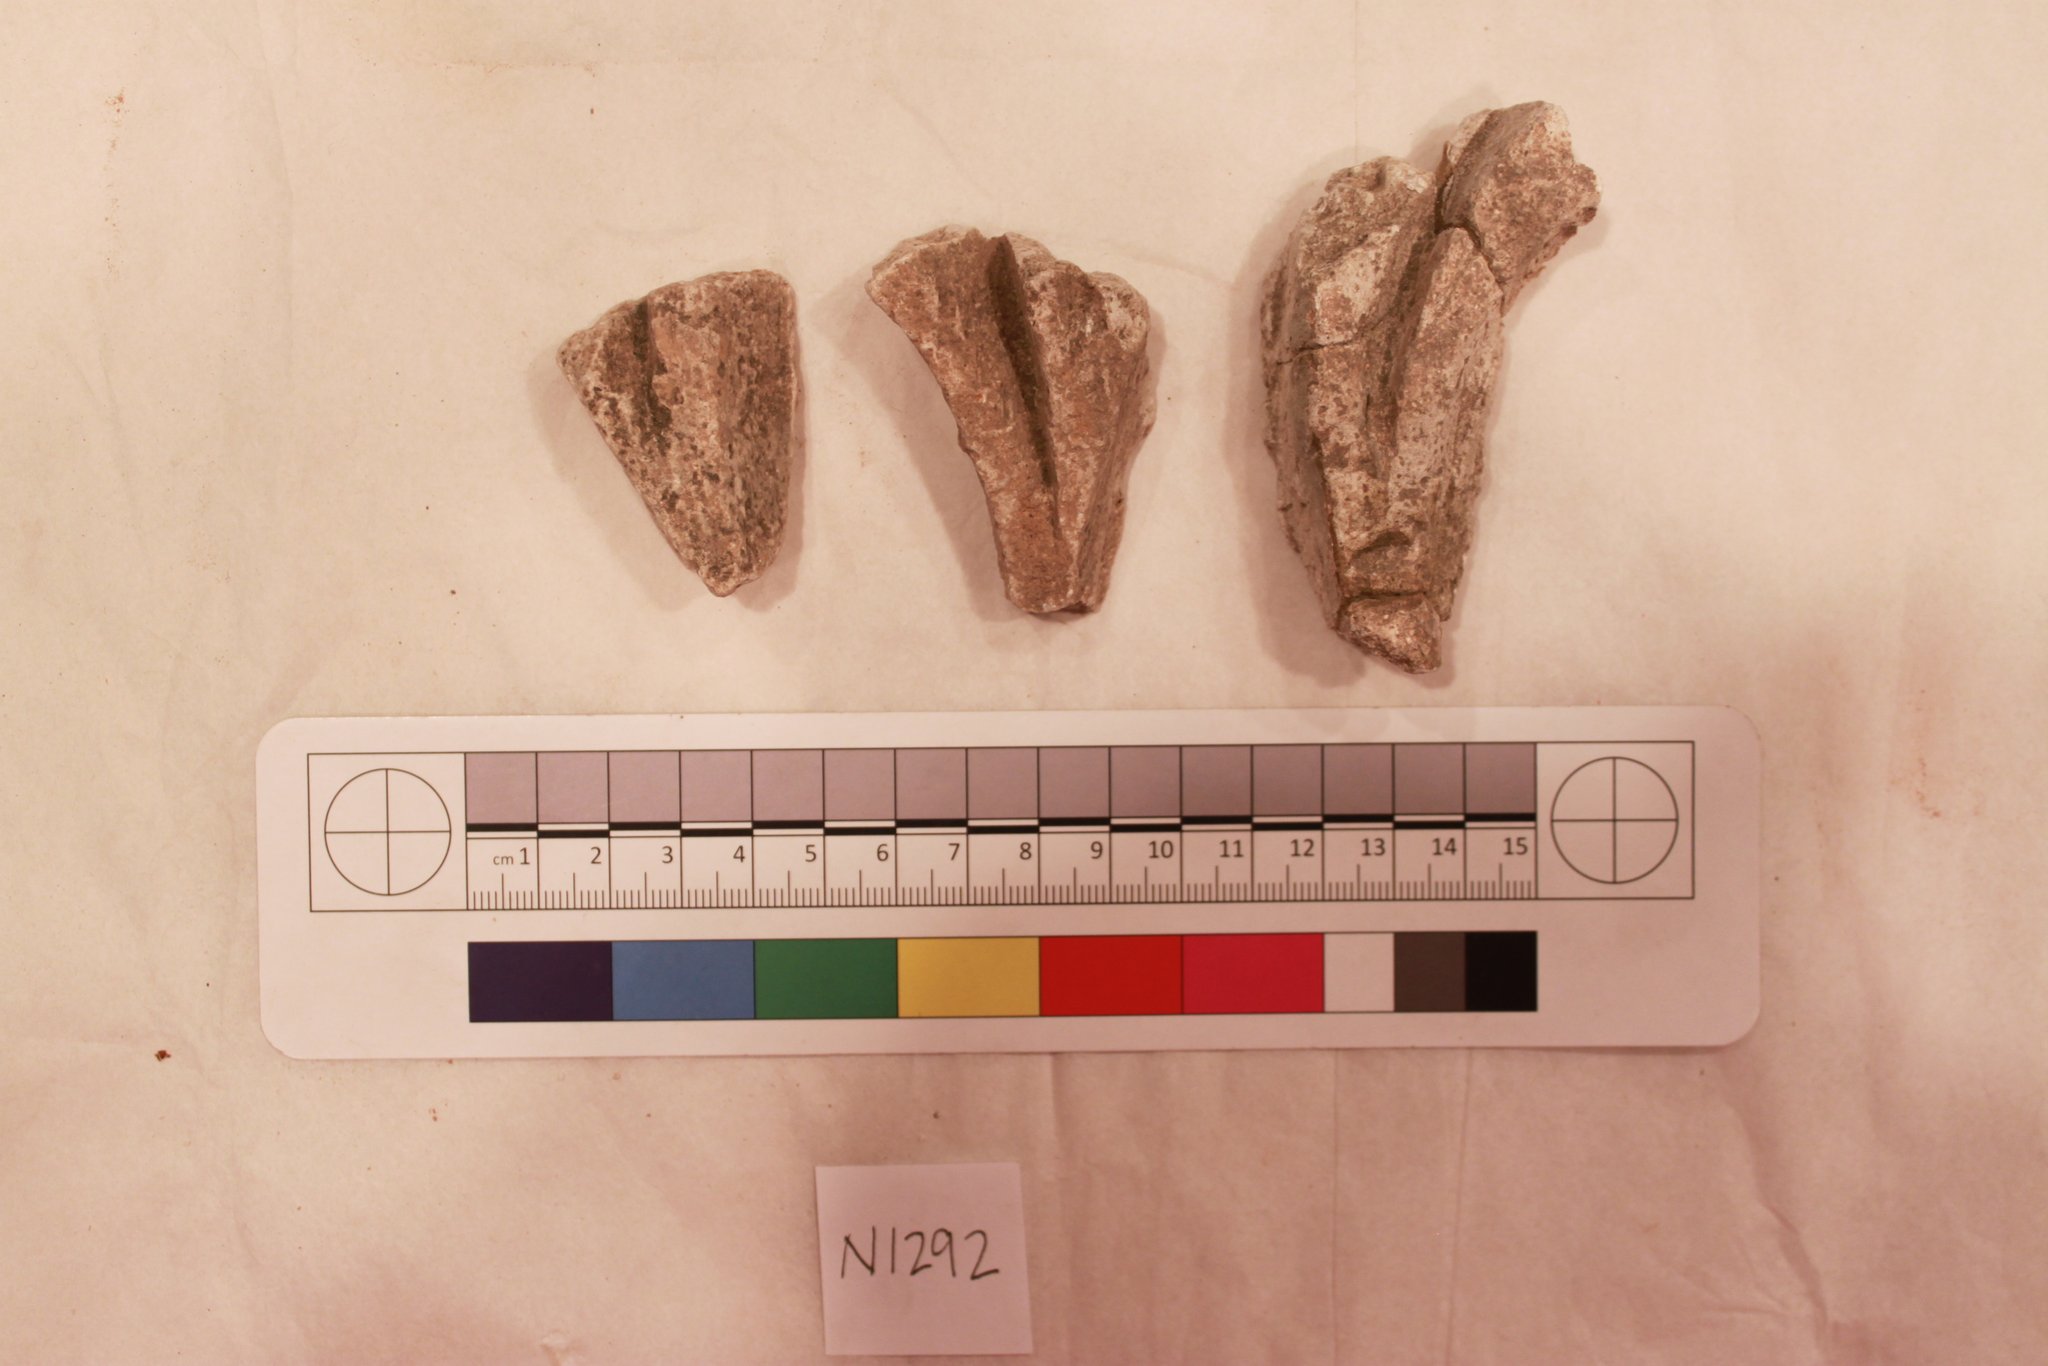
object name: fragment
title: Stucco Fragment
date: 701-1200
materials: plaster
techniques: carving, painting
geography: iran